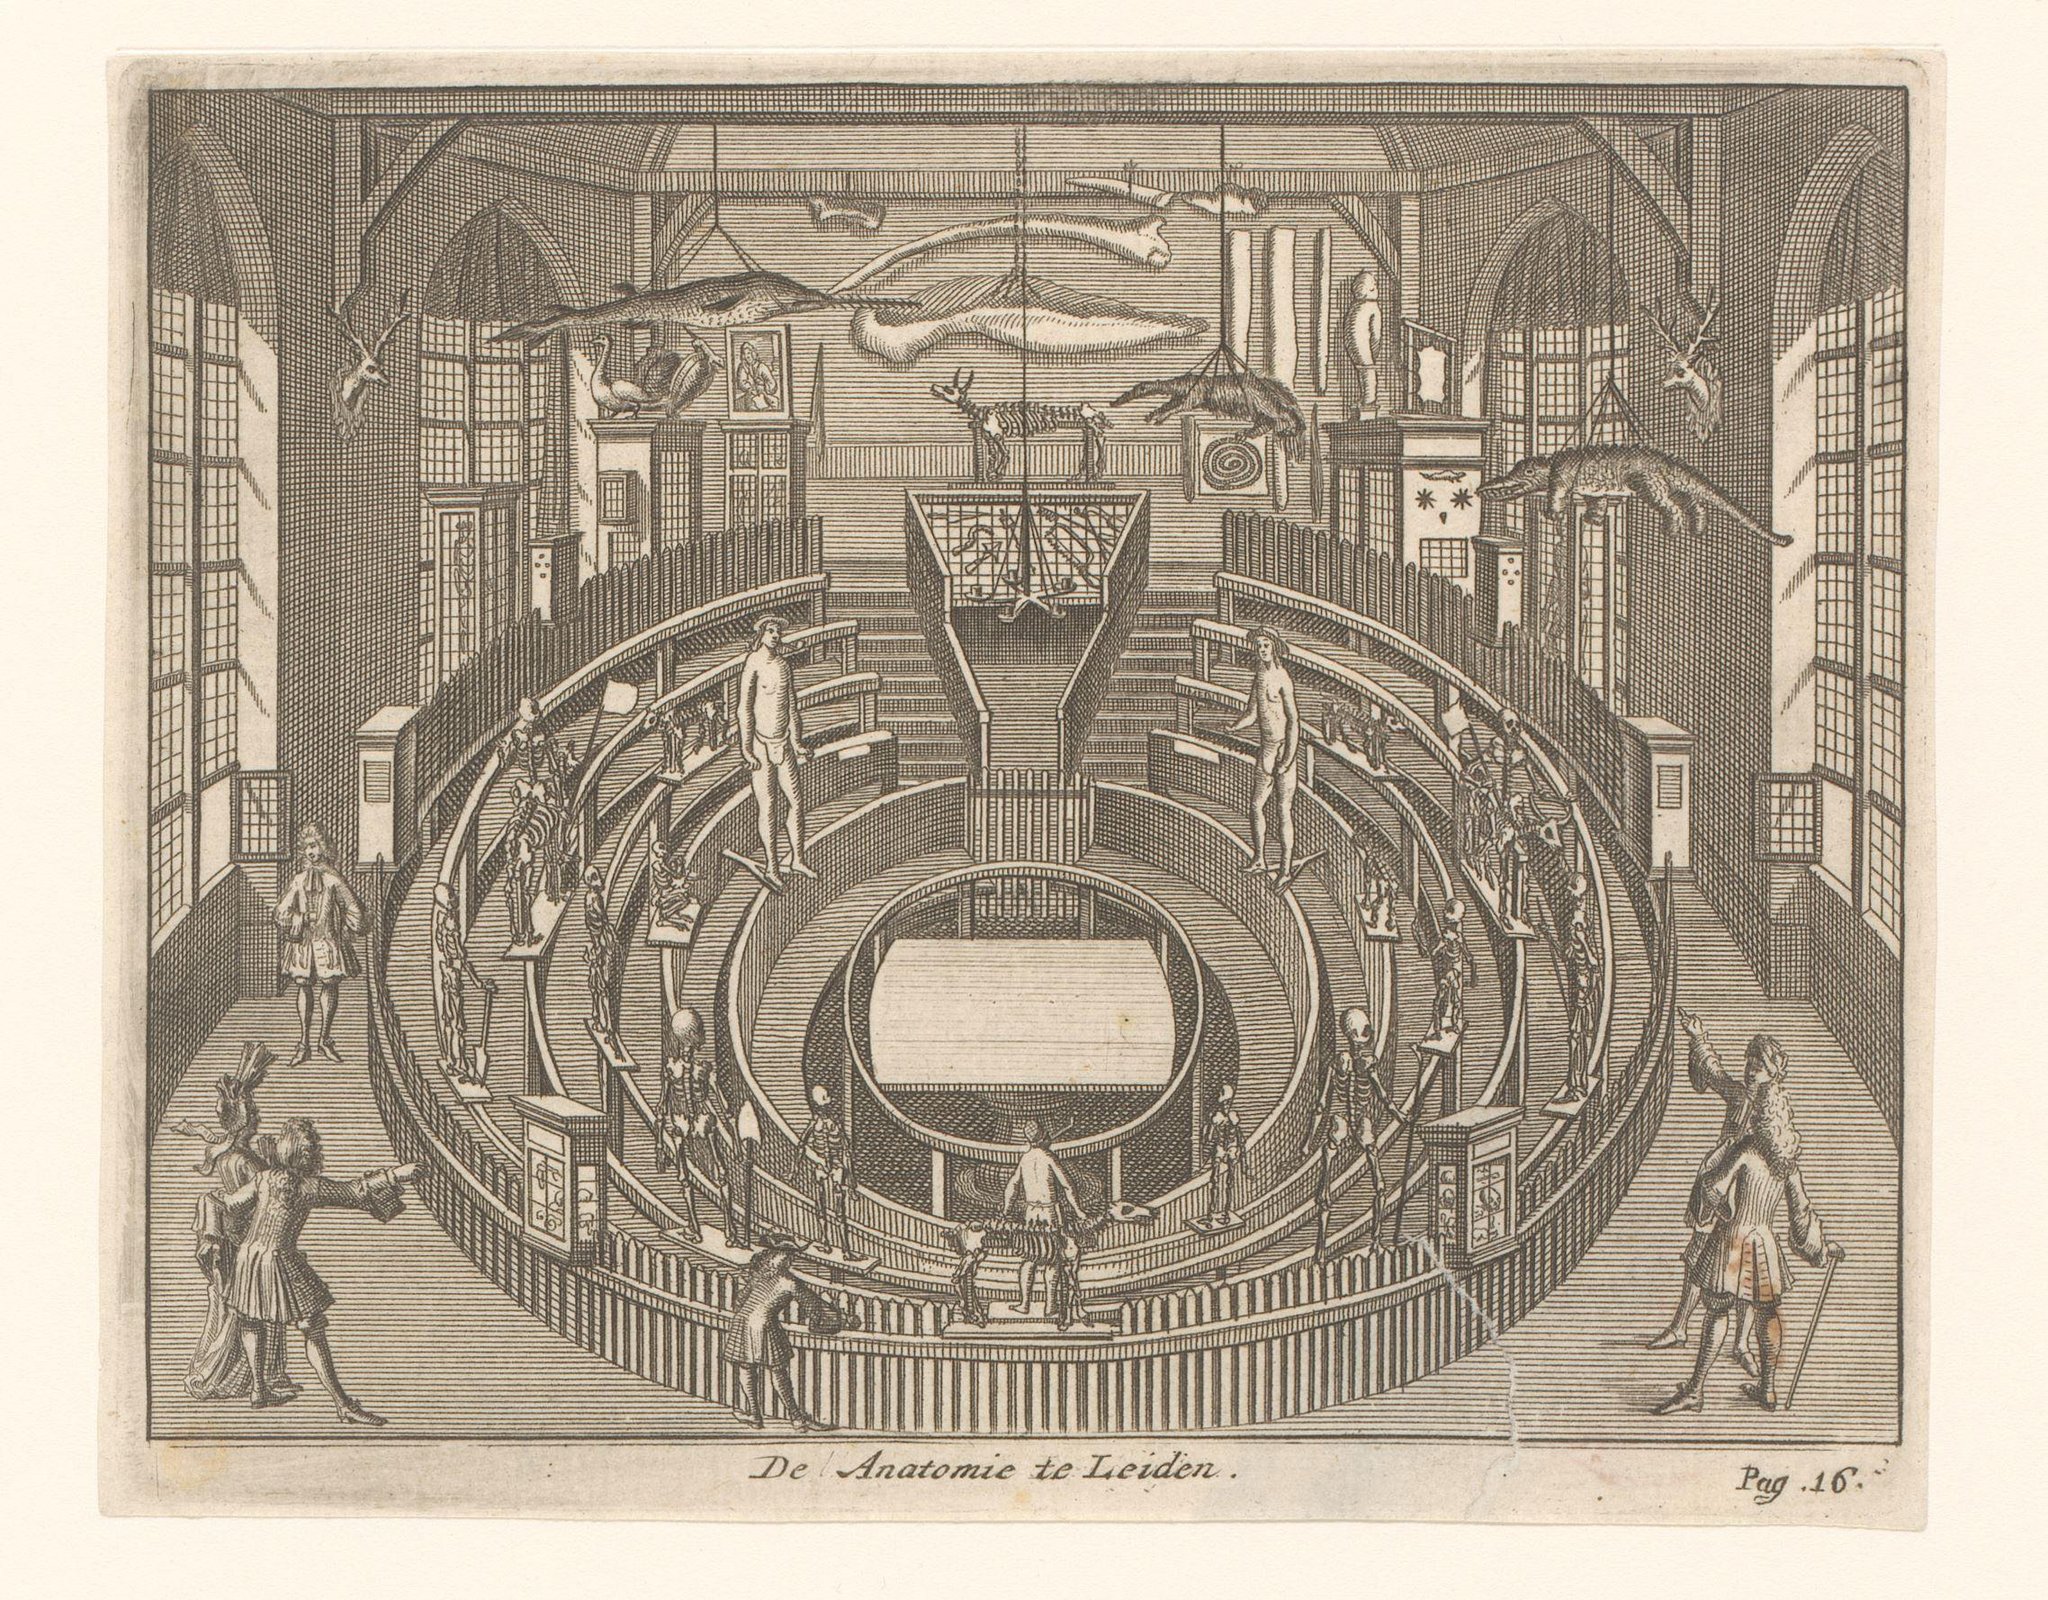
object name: book illustration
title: De Anatomie te Leiden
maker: Anonymous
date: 1726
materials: paper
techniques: etching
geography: northern netherlands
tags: university, anatomy lesson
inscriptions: collector's mark: Lugt 240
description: Prent op p. 16, van een onbekend boek. Prent ook gebruikt in deel 13 van het prentwerk: 'Les Forces de l'Europe, Asie, Afrique et Amerique (...) Comme aussi les Cartes des Côtes de France et d'Espagne' uit 1726, zie RP-P-OB-83.036-68. Voor het merendeel zijn deze platen gekopieerd naar de anonieme Franse platen van vermaarde sterke steden en vestingen in 'Les forces de l'Europe' en in 'Le theatre de la guerre, dans les Pays-Bas', beide oorspronkelijk uitgegeven door Nicolas de Fer (1693-1697) te Parijs, in het kader van de Negenjarige Oorlog. Titel in het Latijn.